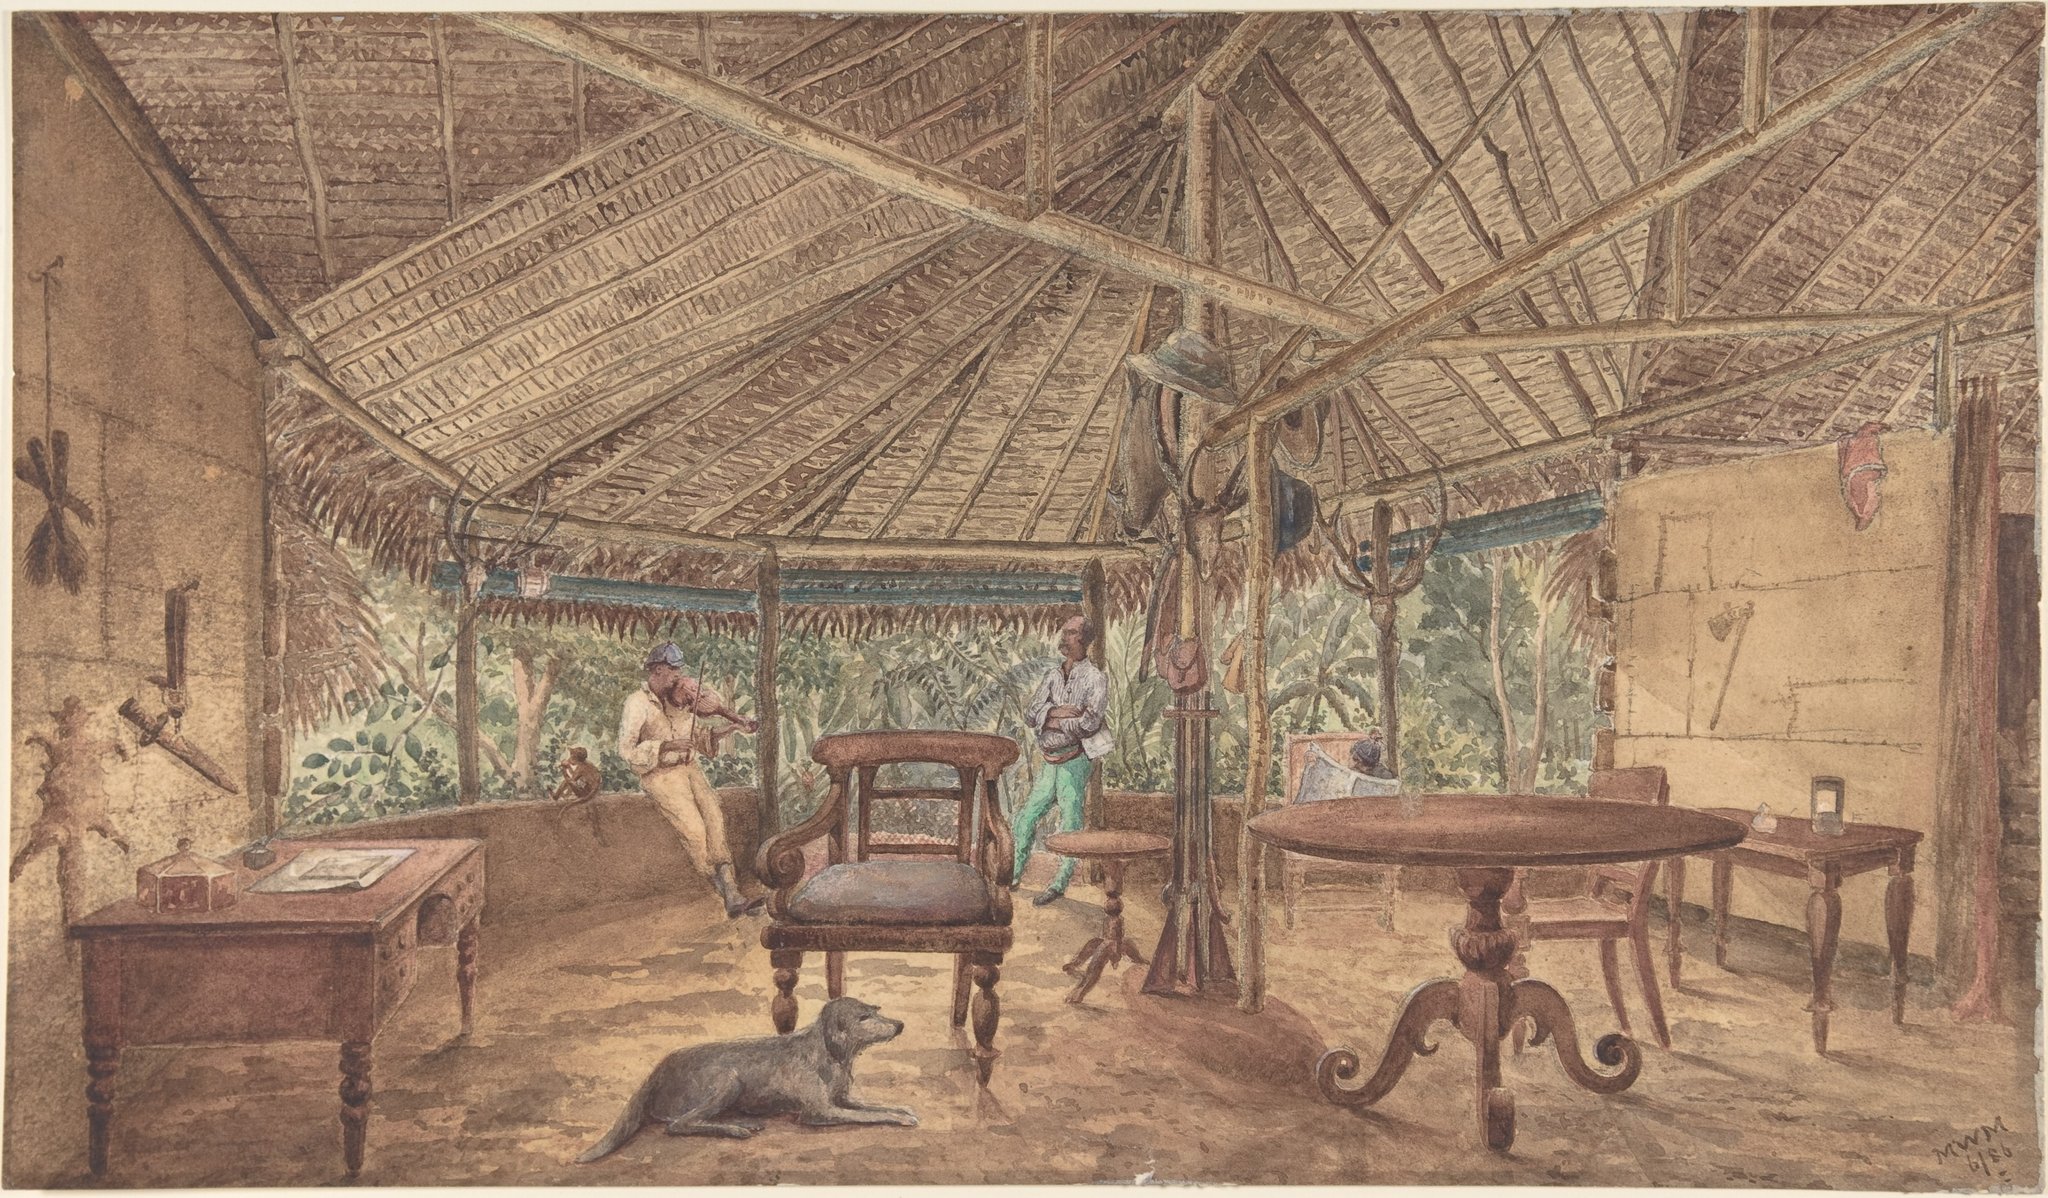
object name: drawing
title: European Men in an African Jungle Lodge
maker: anonymous, british, 19th century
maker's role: artist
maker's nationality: british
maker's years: 1800-1900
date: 1886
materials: watercolor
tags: houses,men,dogs,chairs,tables